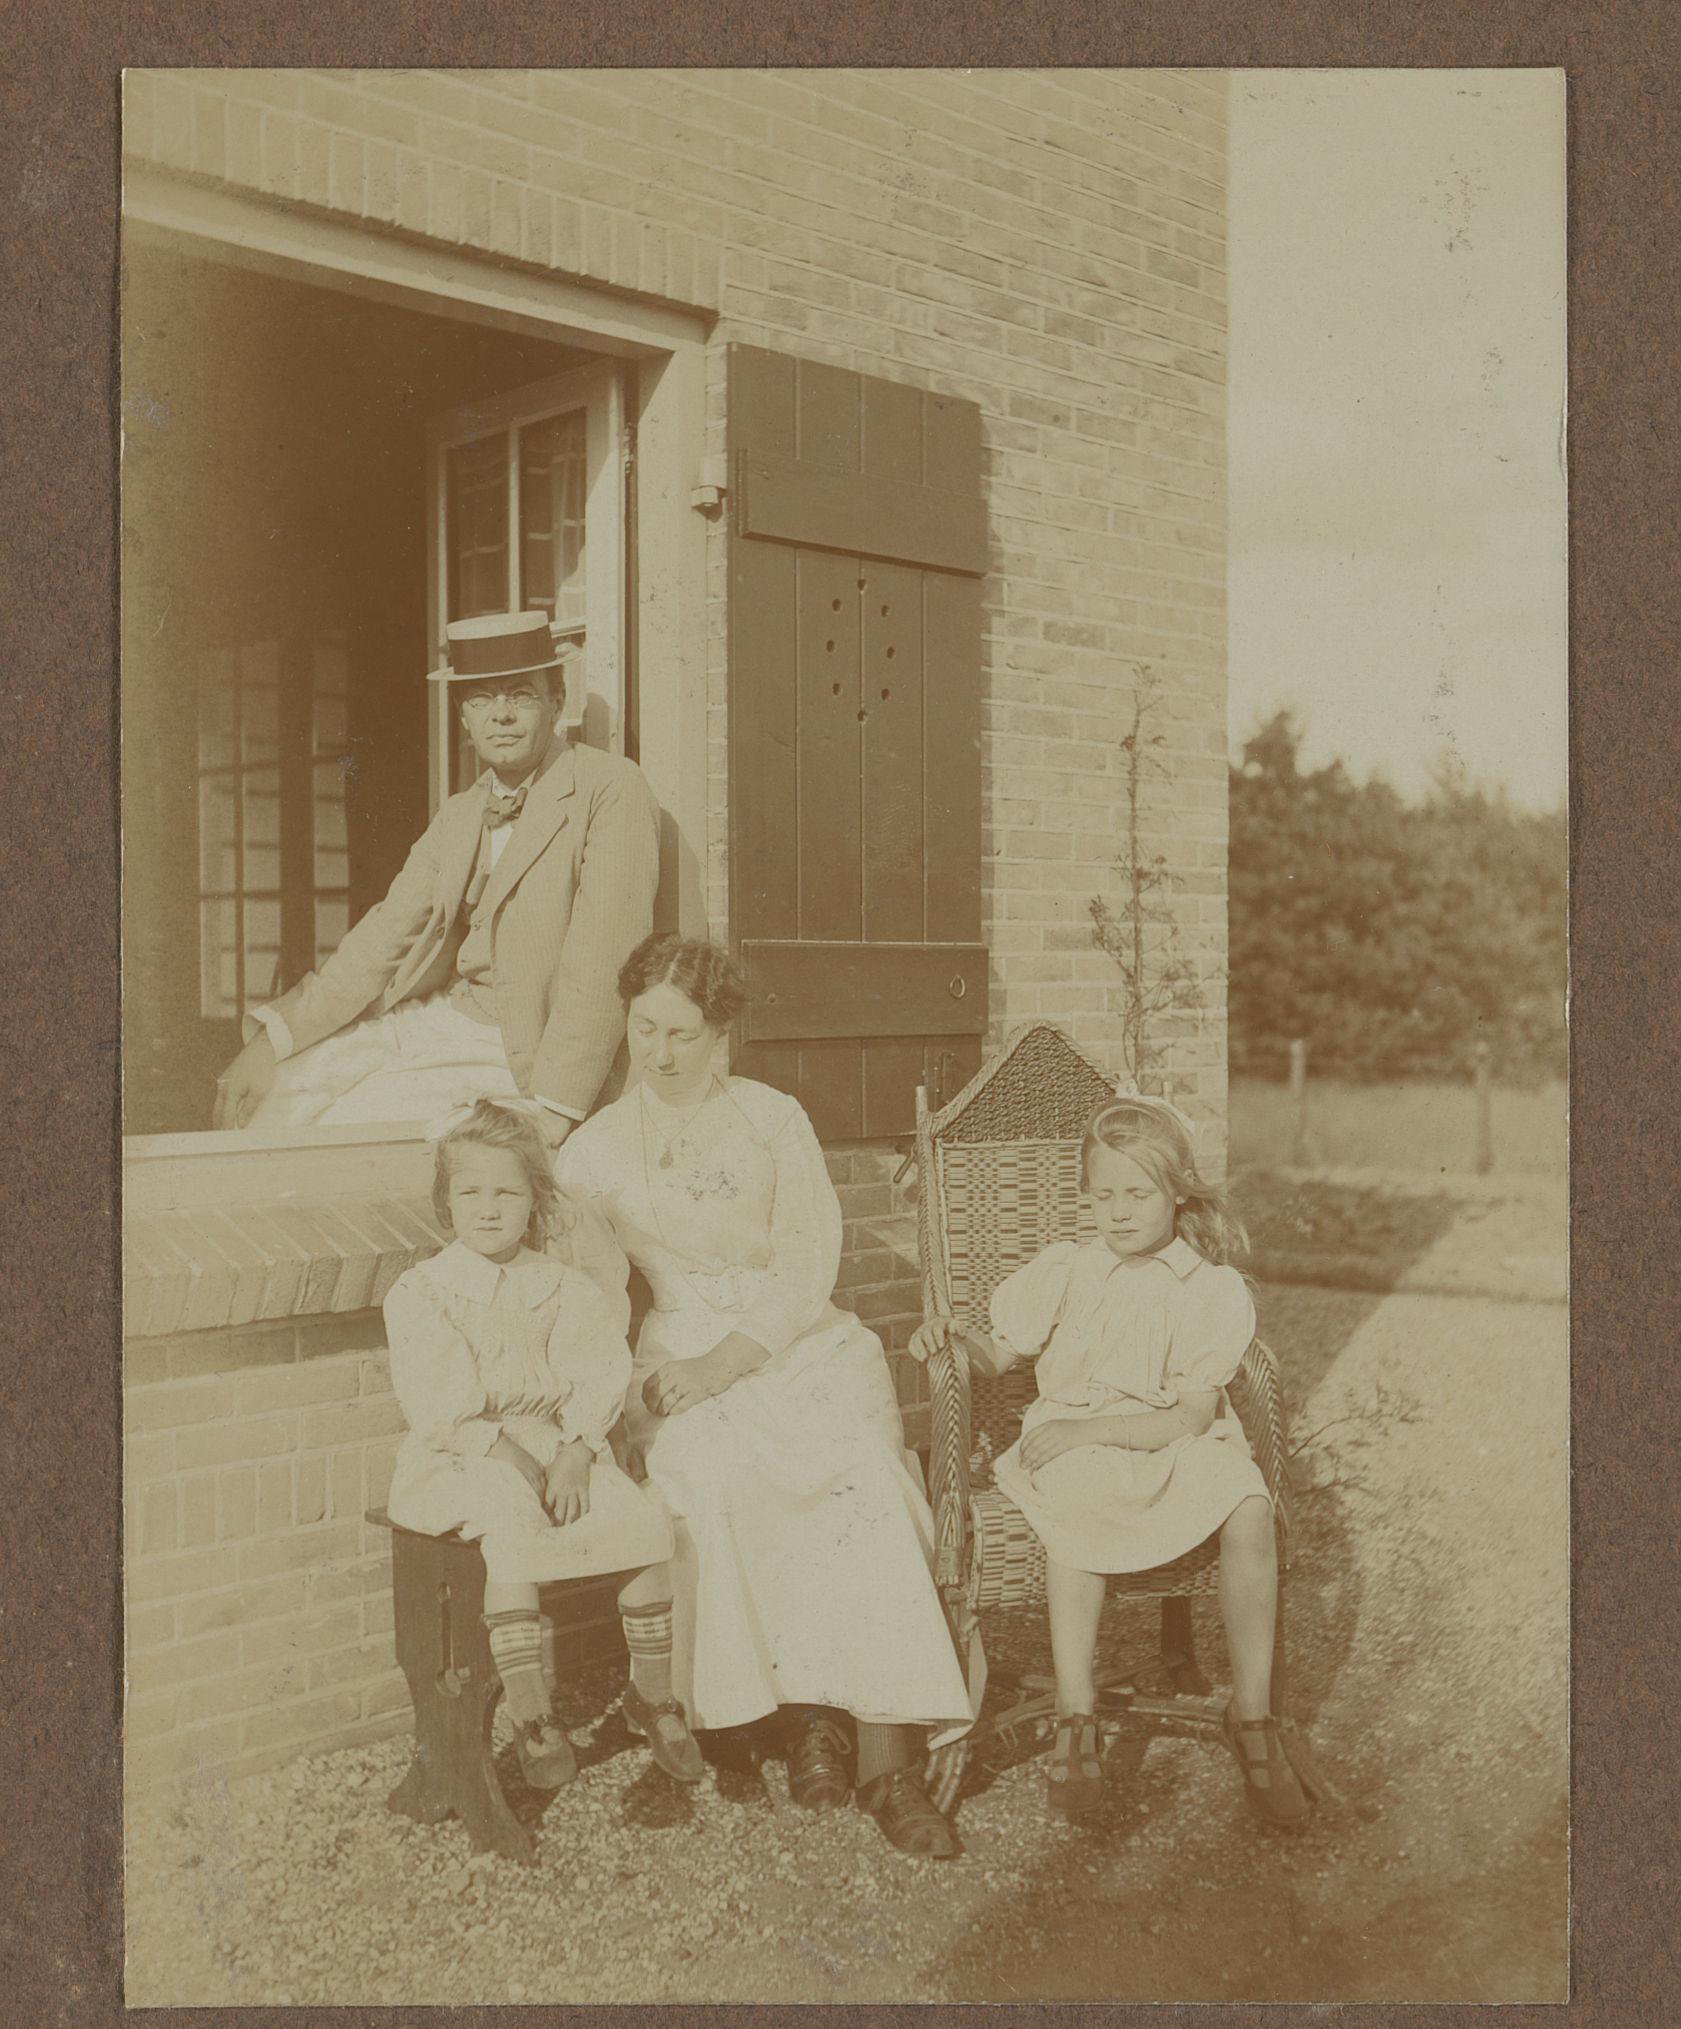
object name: photograph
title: Alphons Diepenbrock met zijn gezin in de Holtwiek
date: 1911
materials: photographic support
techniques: photography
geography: amsterdam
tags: alphons diepenbrock, jonkvrouw wilhelmina elisabeth petronella cornelia de jong van beek en donk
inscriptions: date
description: Foto op bruin albumblad 9 van familiealbum van Alphons Diepenbrock.